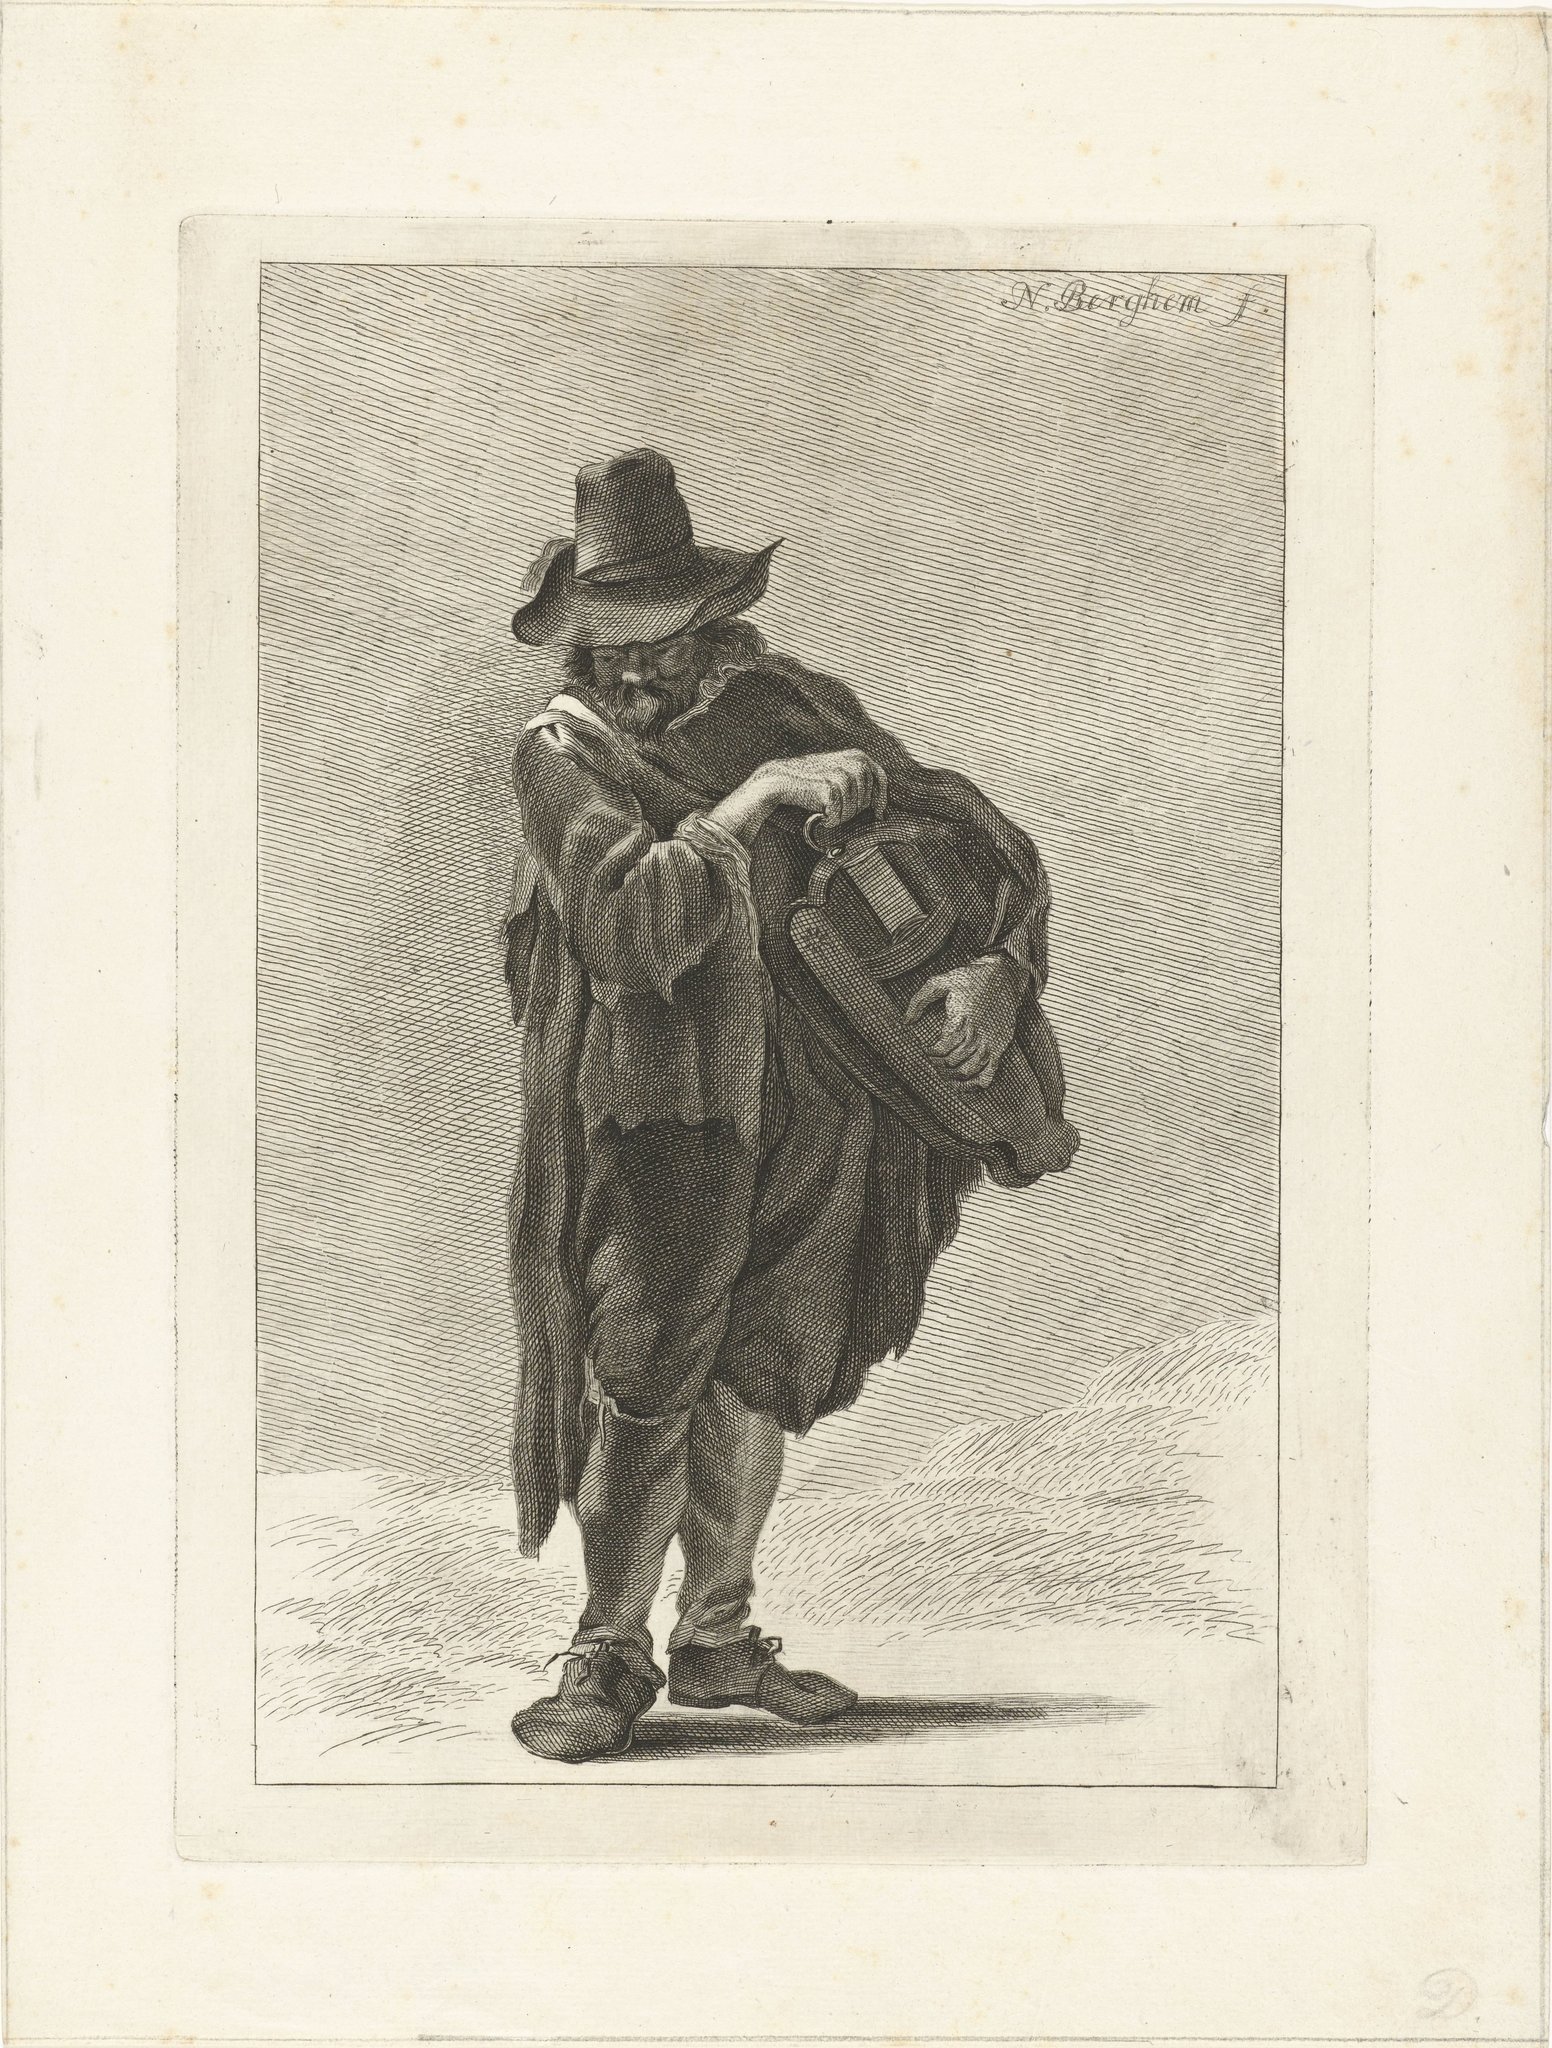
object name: print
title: Liereman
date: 1768-1796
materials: paper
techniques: engraving, etching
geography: leiden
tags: hurdy-gurdy player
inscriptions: collector's mark: Lugt 2233